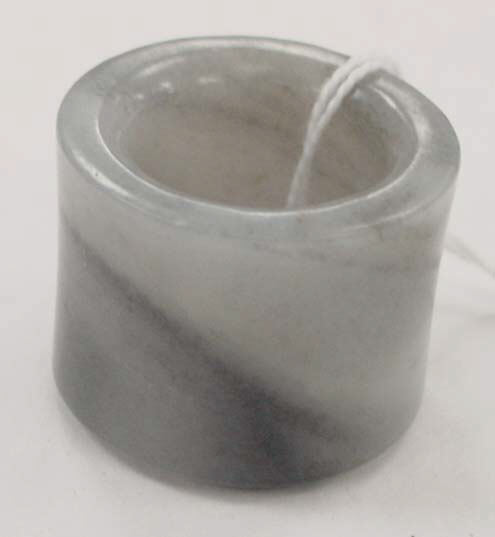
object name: ring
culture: chinese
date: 1801-1900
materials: jade